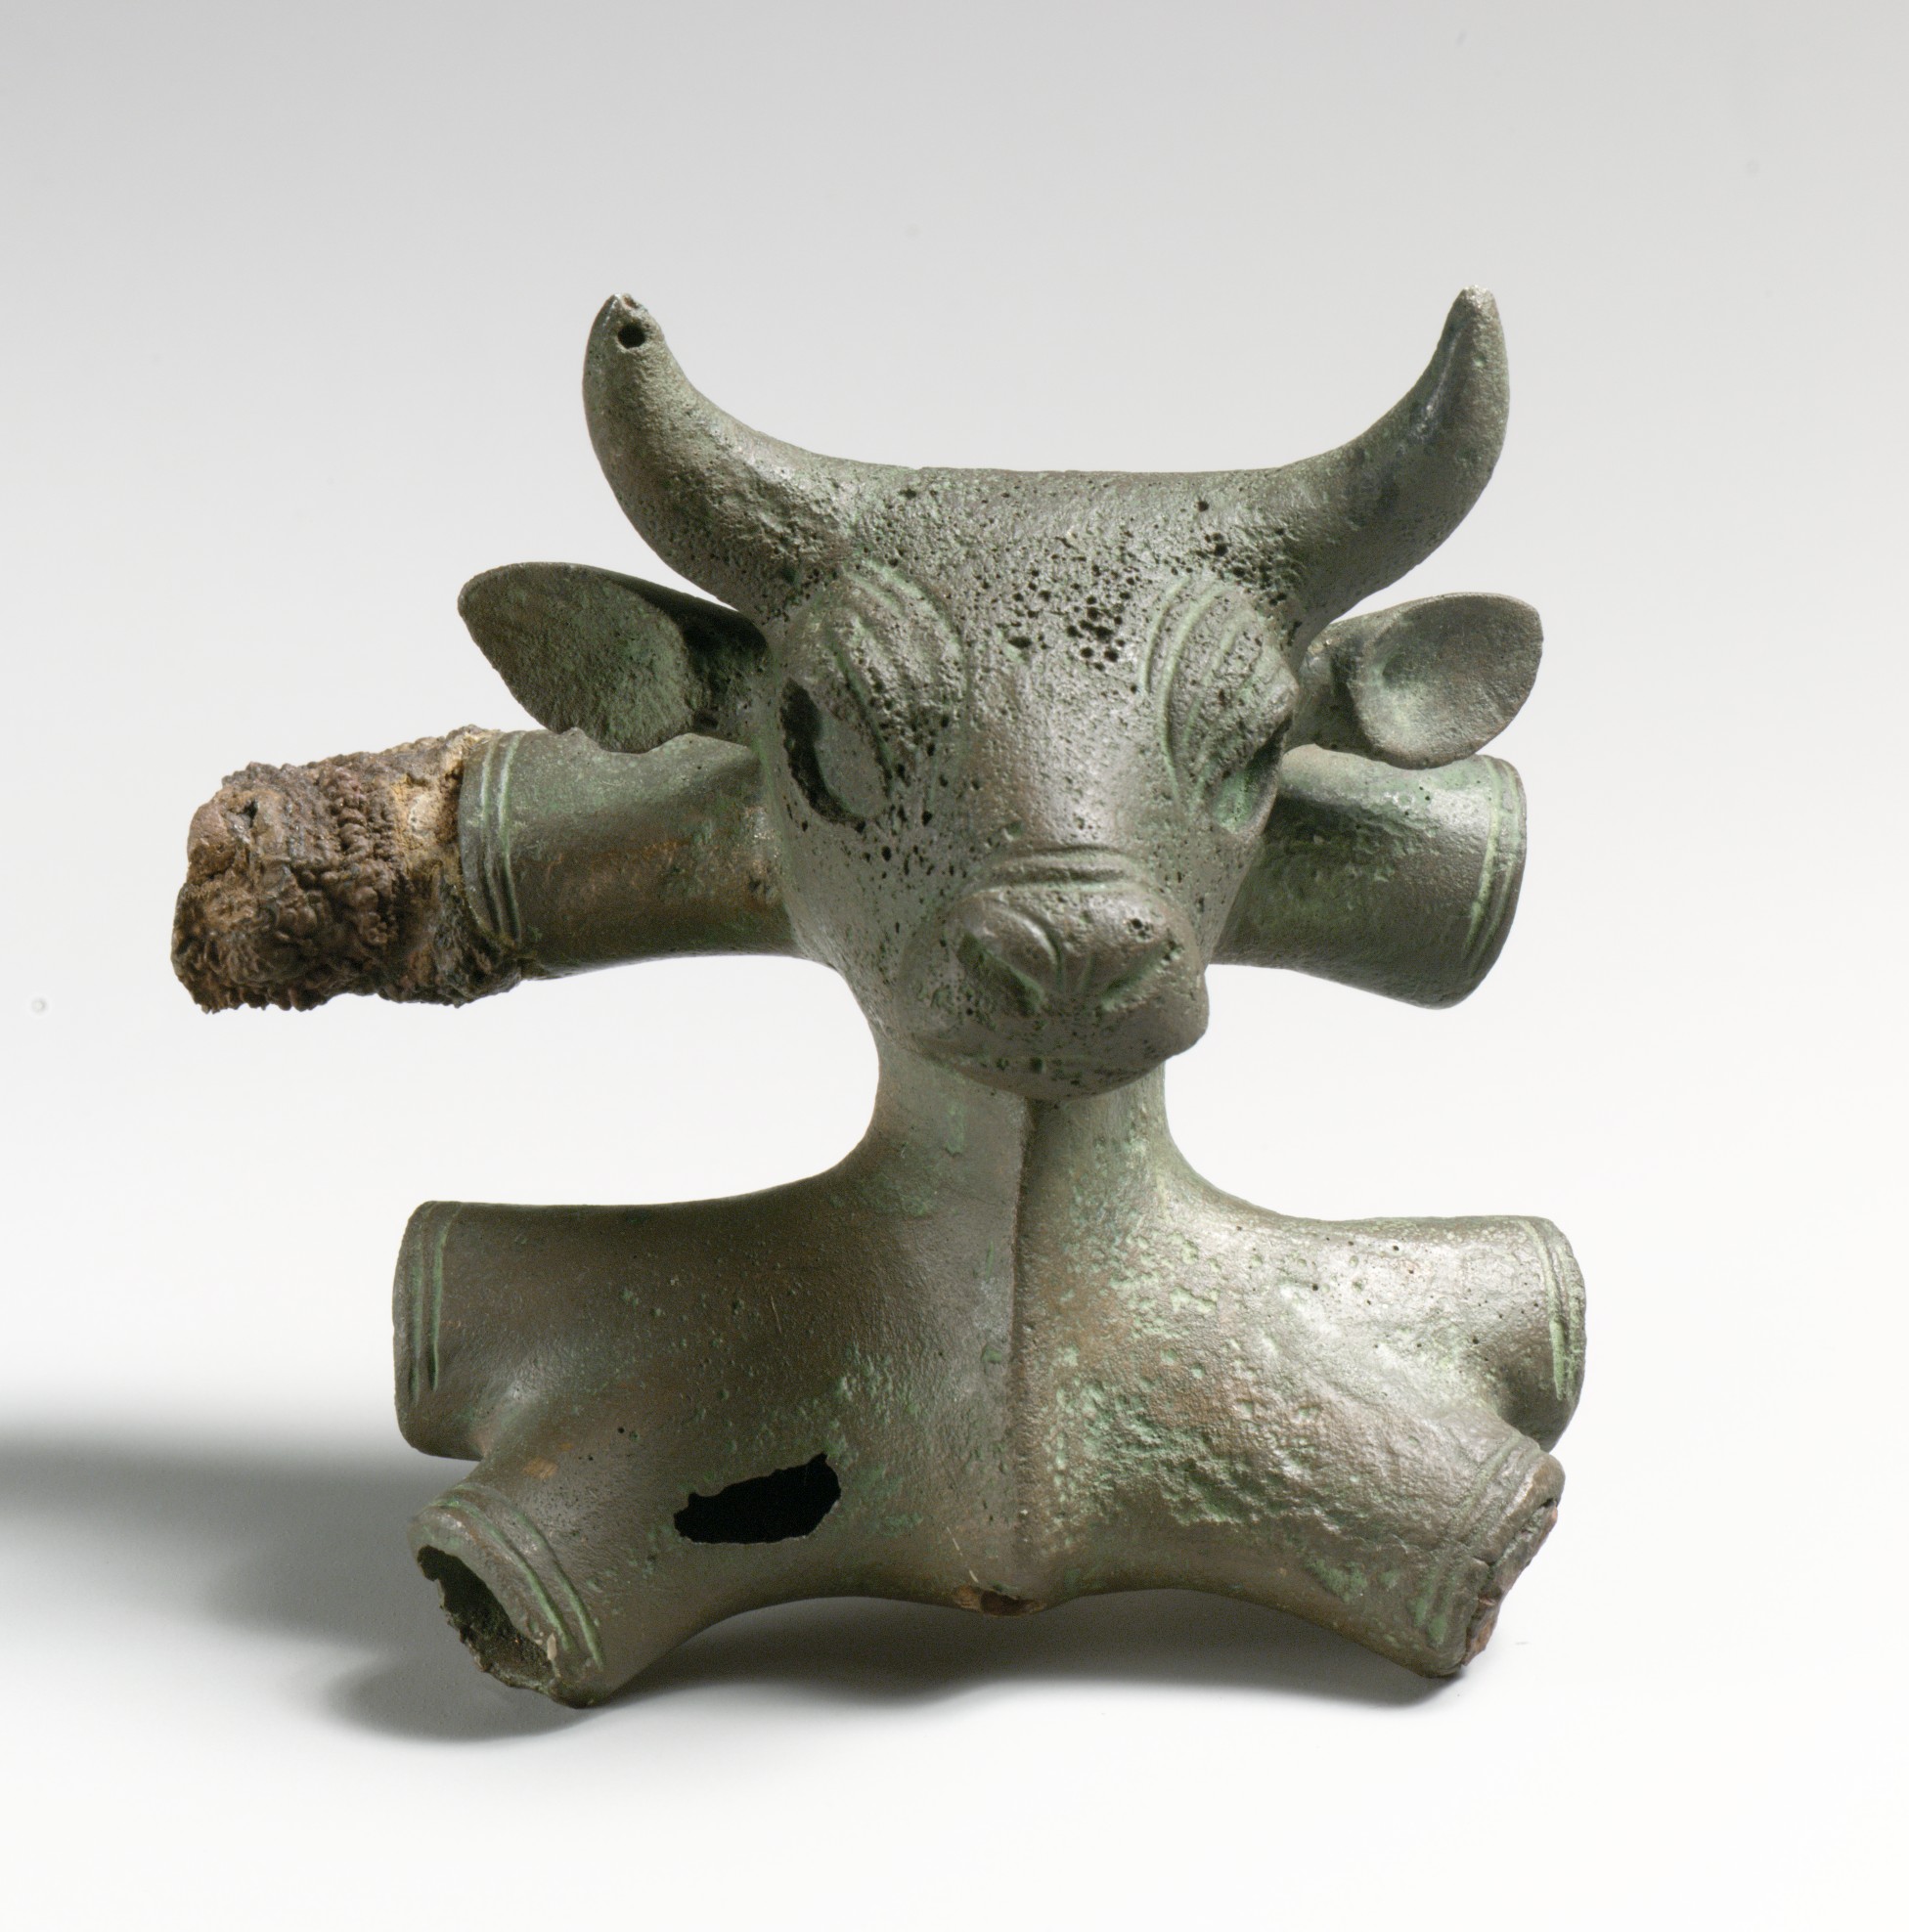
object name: attachment in the form of a bull's head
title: Bronze bull's head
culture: cypriot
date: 700-668 BCE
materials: bronze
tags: bulls